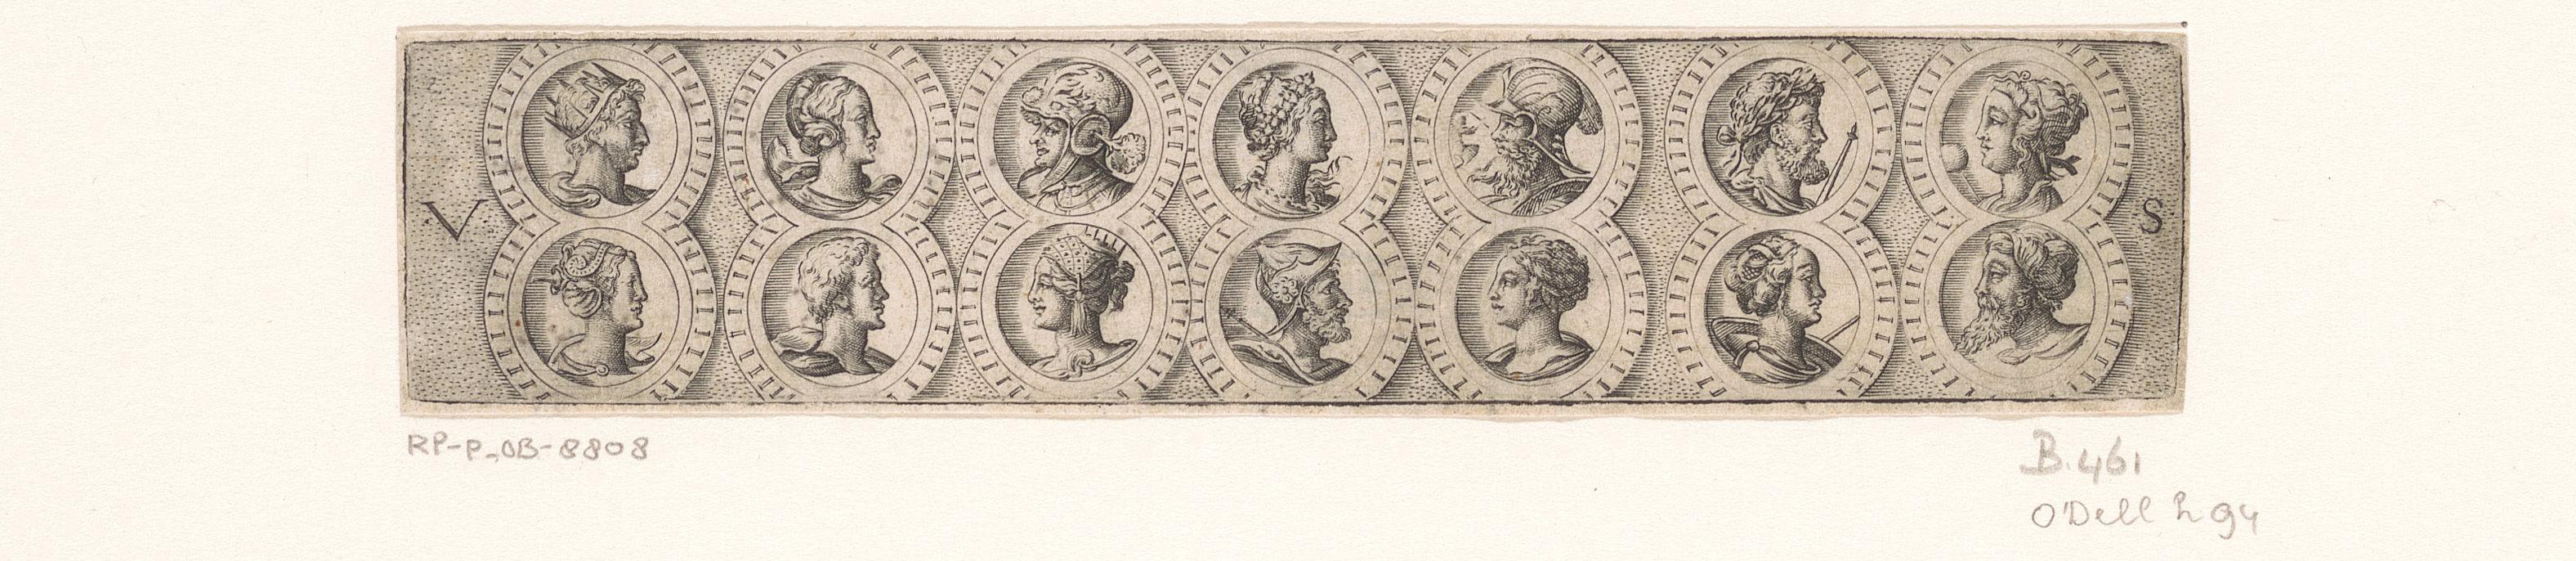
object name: print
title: Fries met veertien bustes in twee rijen medaillons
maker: virgilius solis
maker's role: draughtsman, print maker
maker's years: 1514-1562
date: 1524-1562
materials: paper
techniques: engraving, intaglio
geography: nuremberg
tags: chest, bust, head-gear, medal (considered as a piece of sculpture, regardless of its specific function)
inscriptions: collector's mark: Lugt 2228